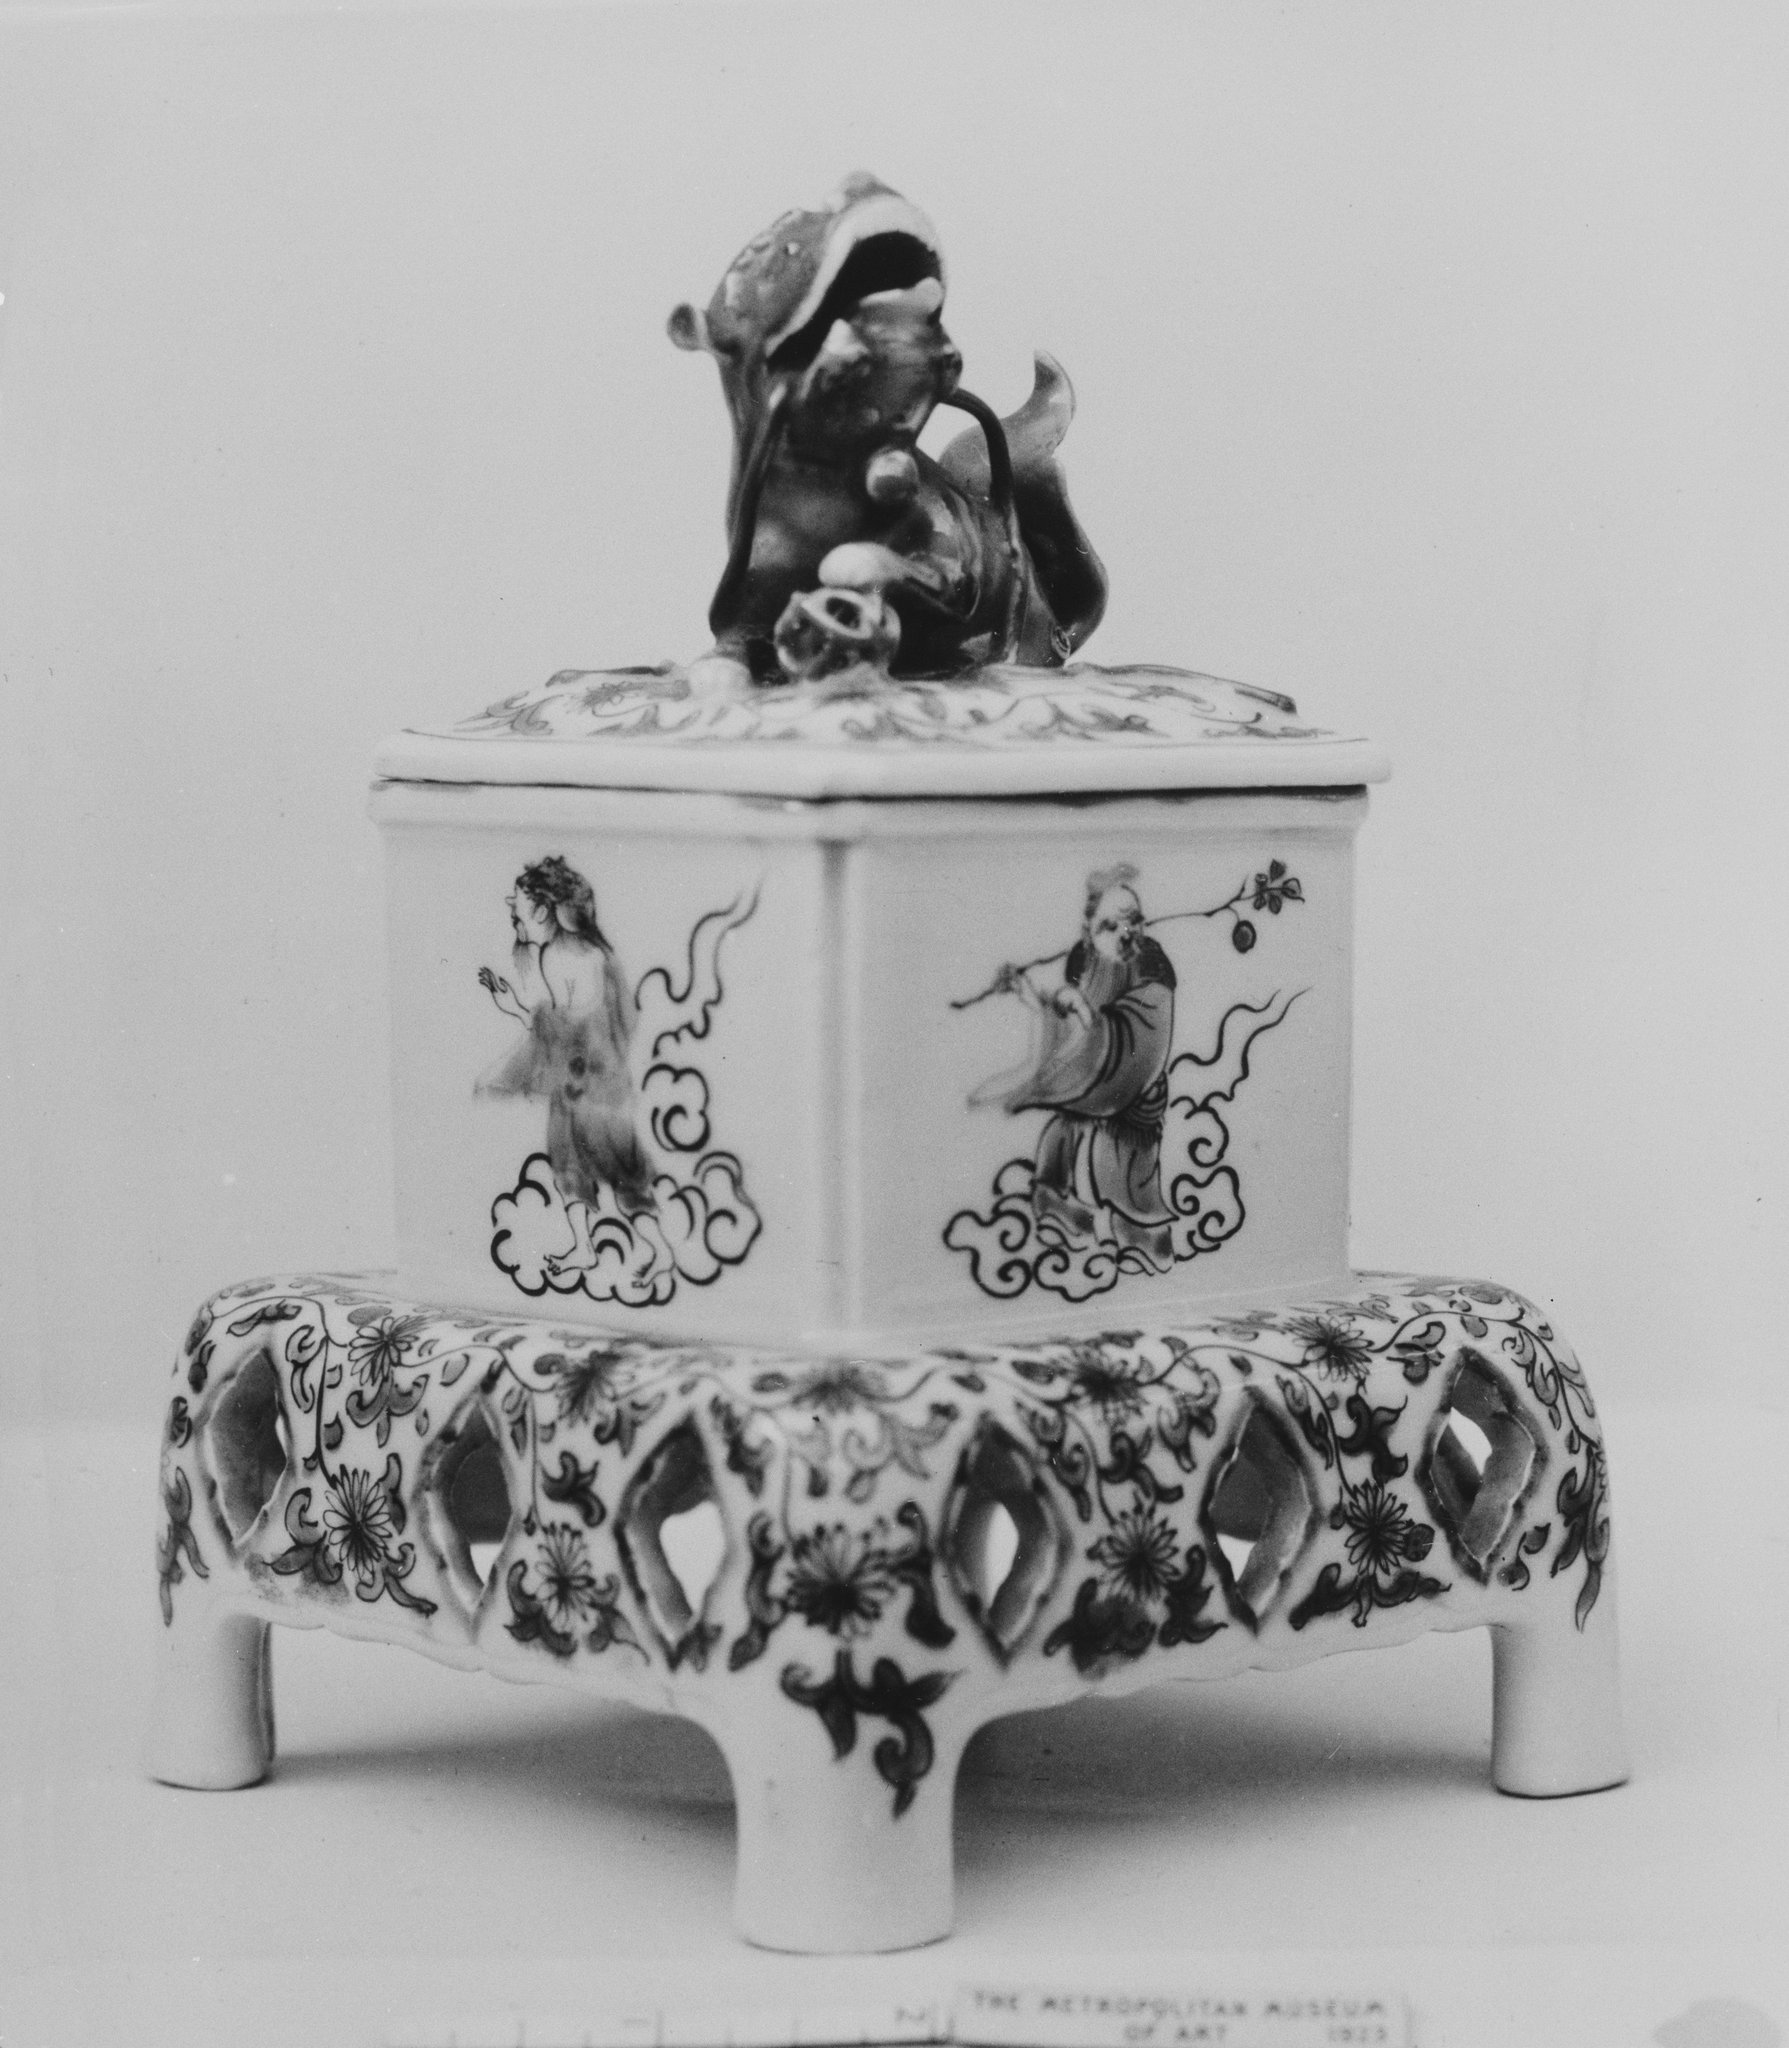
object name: covered censer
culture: japanese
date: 1820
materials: enamel, porcelain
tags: human figures,animals,censers